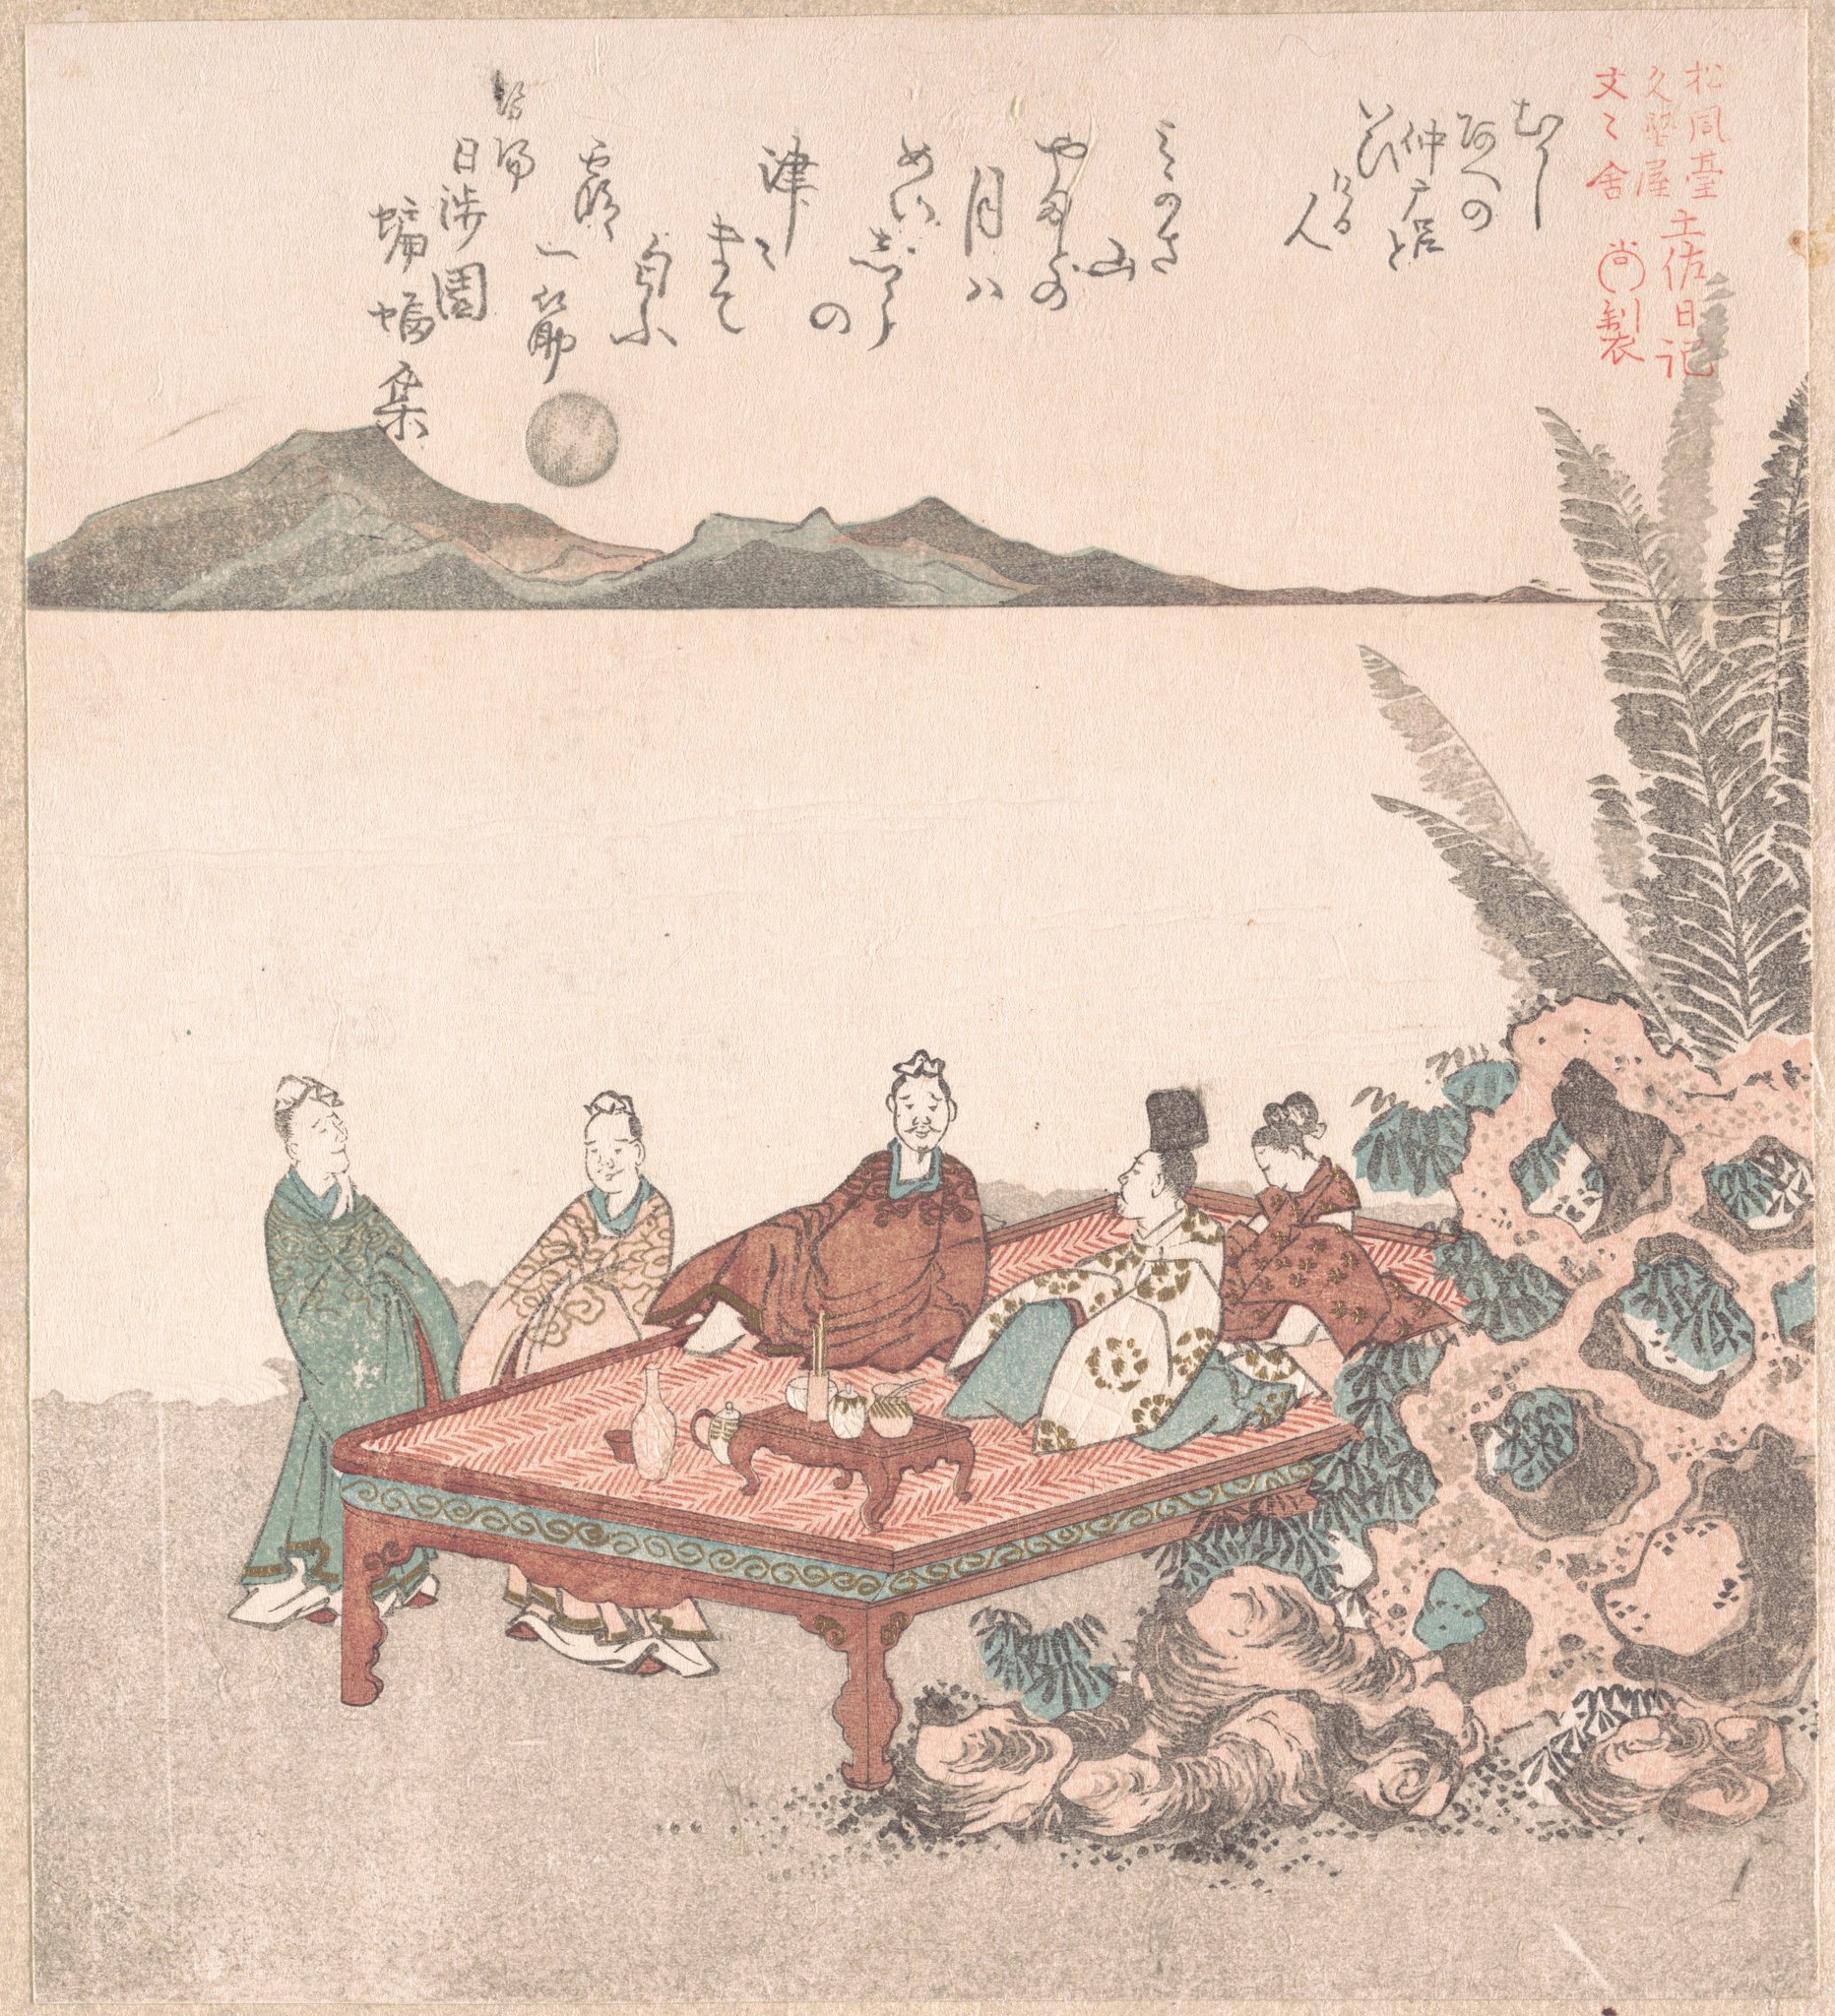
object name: print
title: Nanamaro and His Followers Looking at the Moon in China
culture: japanese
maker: kubo shunman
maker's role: artist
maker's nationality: japanese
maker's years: 1757-1820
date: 1801-1900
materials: ink, paper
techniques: surimono, woodblock print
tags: men,moon,mountains